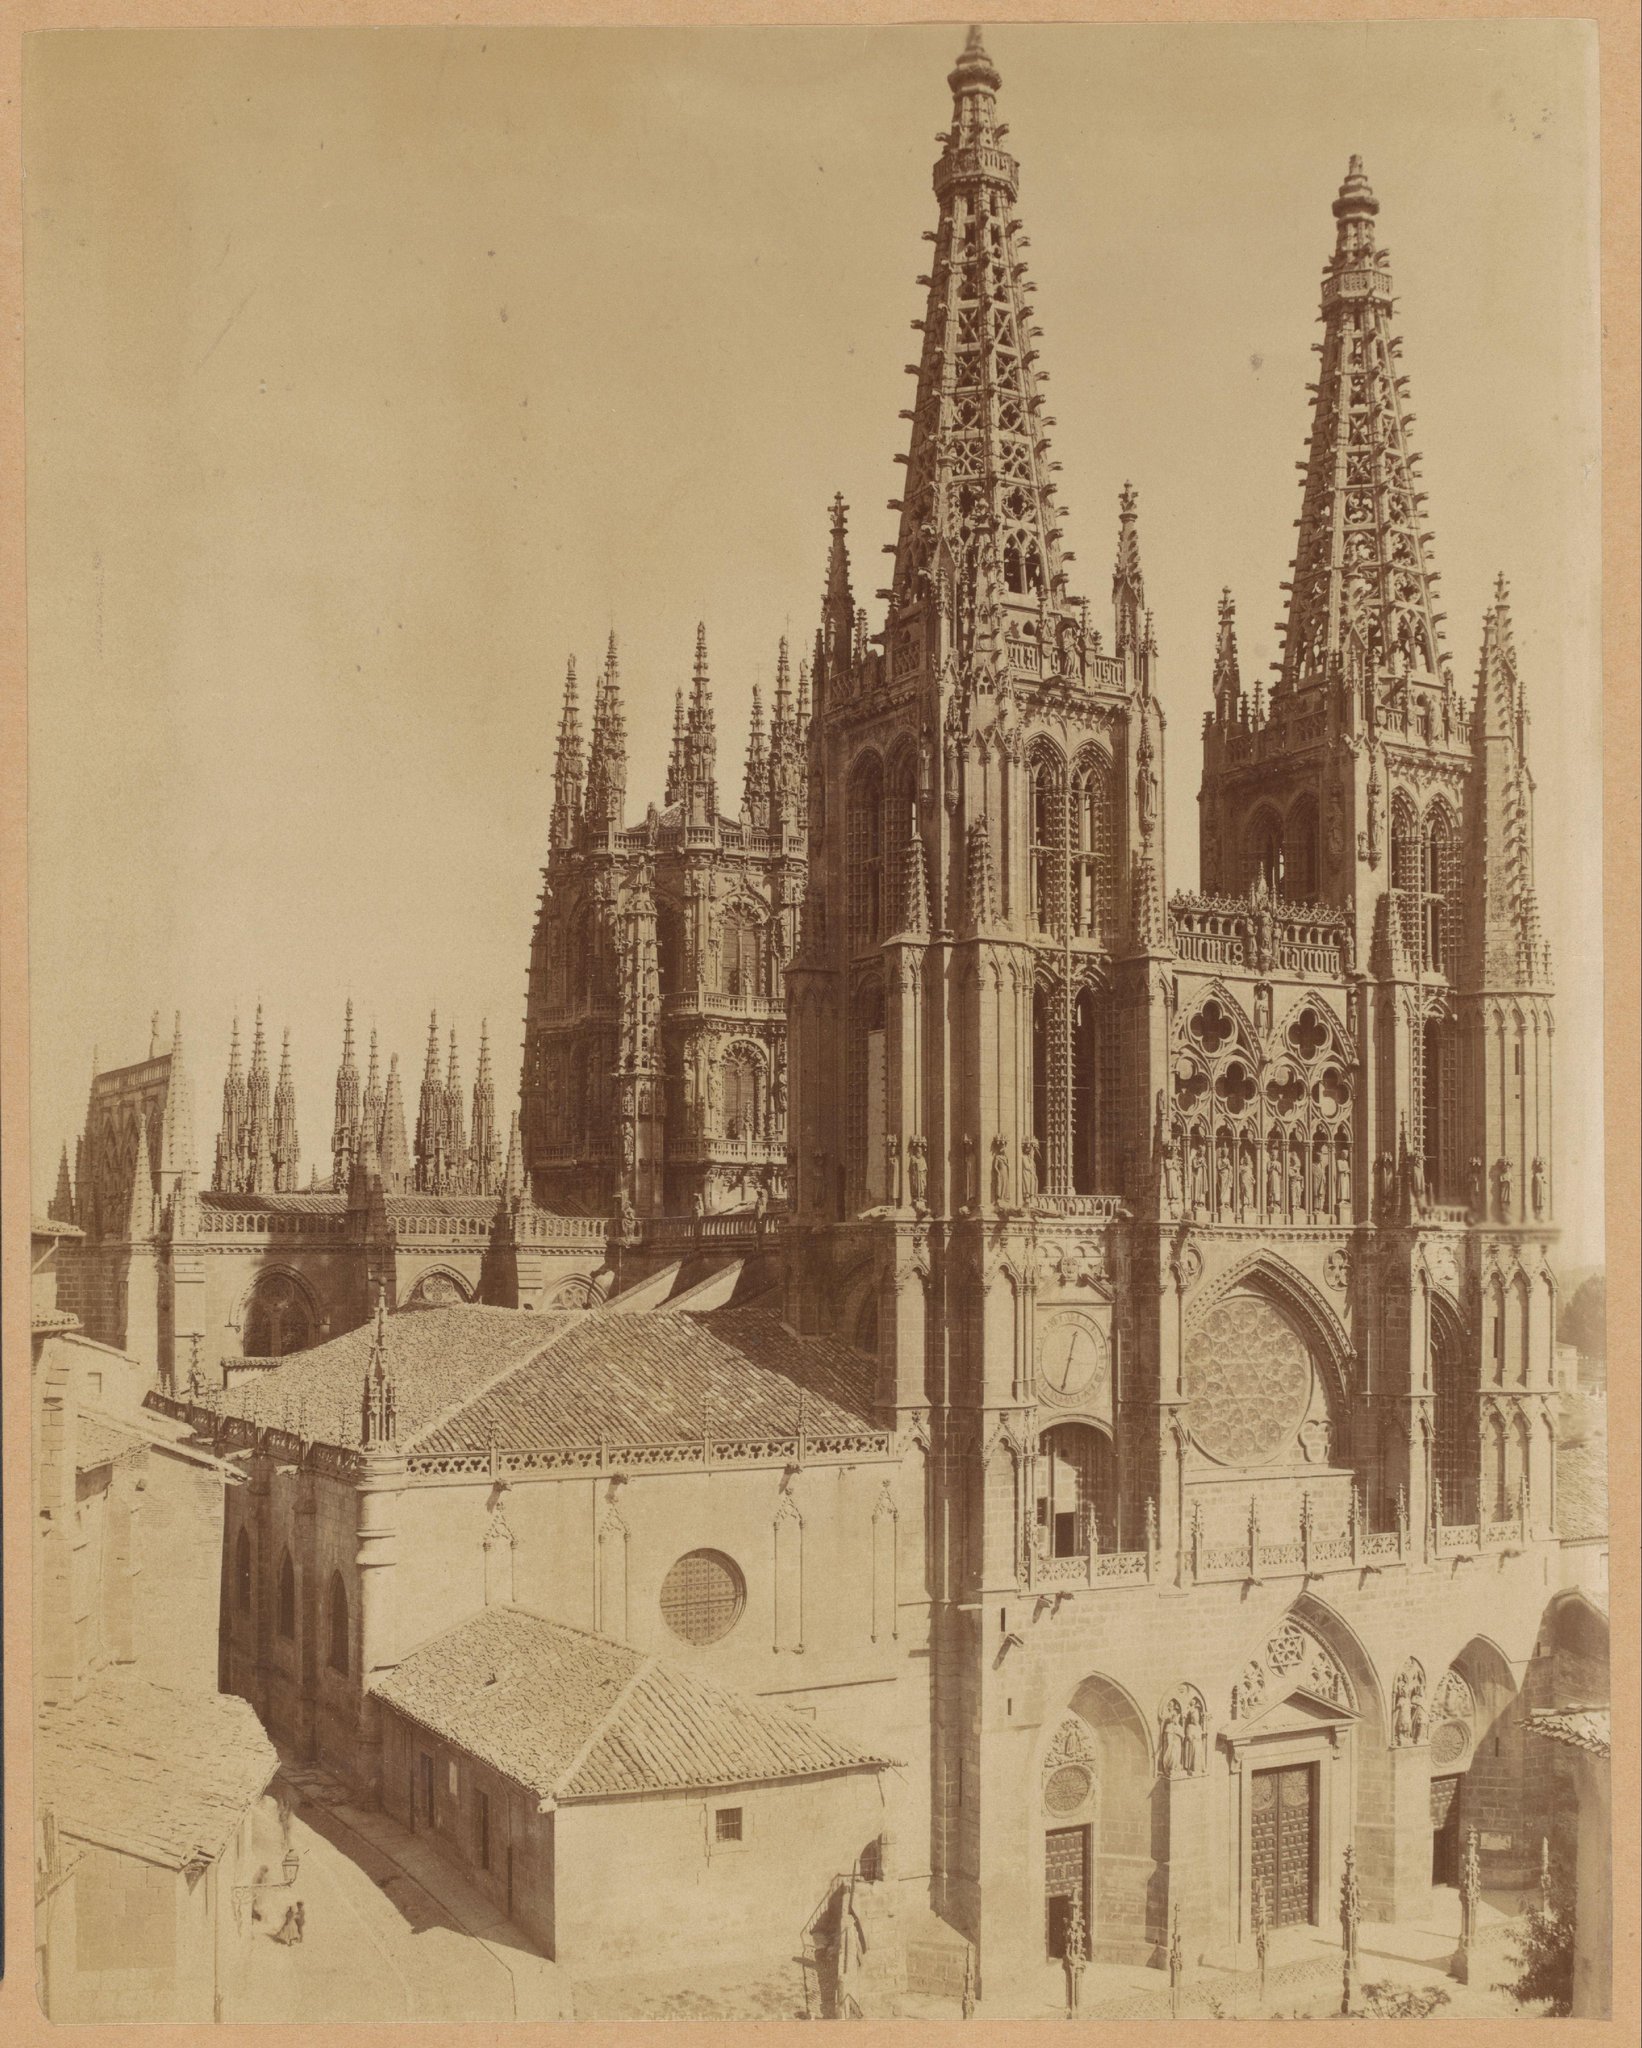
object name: photograph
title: Kathedraal van Burgos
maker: Anonymous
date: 1860-1900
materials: cardboard, photographic support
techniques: albumen print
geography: burgos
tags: church (exterior)